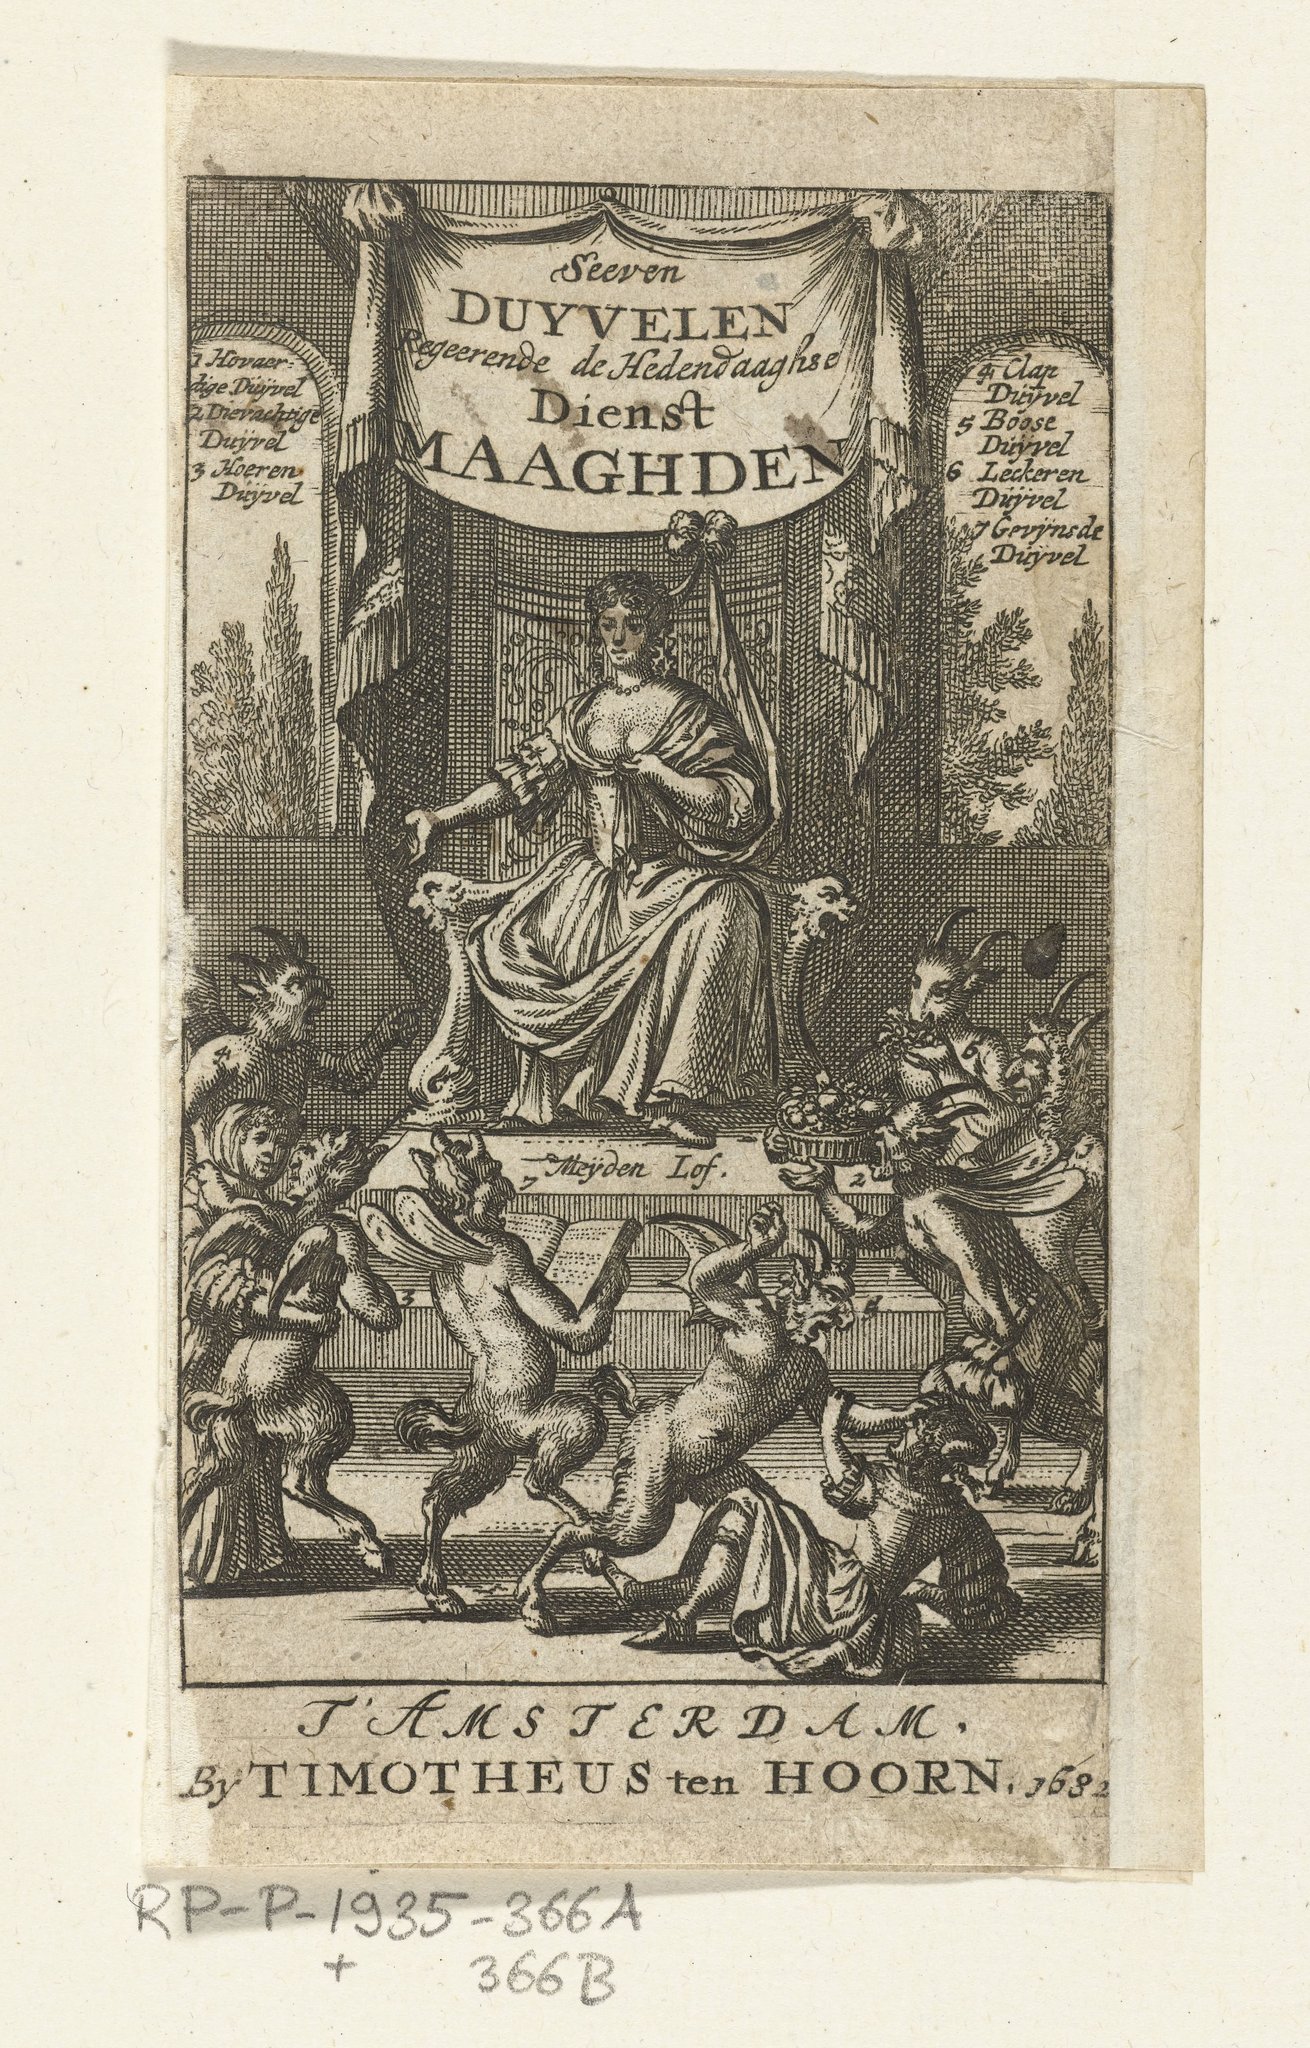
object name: titelblad, titelpagina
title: Titelpagina voor Simon de Vries, Seven Duyvelen regeerende en serveerende de Hedendaeghsche Dienstmaegden, Amsterdam, 1682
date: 1682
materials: paper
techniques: etching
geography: amsterdam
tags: christian religion (+ devil(s)), maid ~ house personnel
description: Een vrouw zit op een troon. Om haar heen spelen de zeven duivels van de dienstmaagden. Aan weerszijden van haar troon is op de ramen een legenda met de namen van de verschillende duivels.